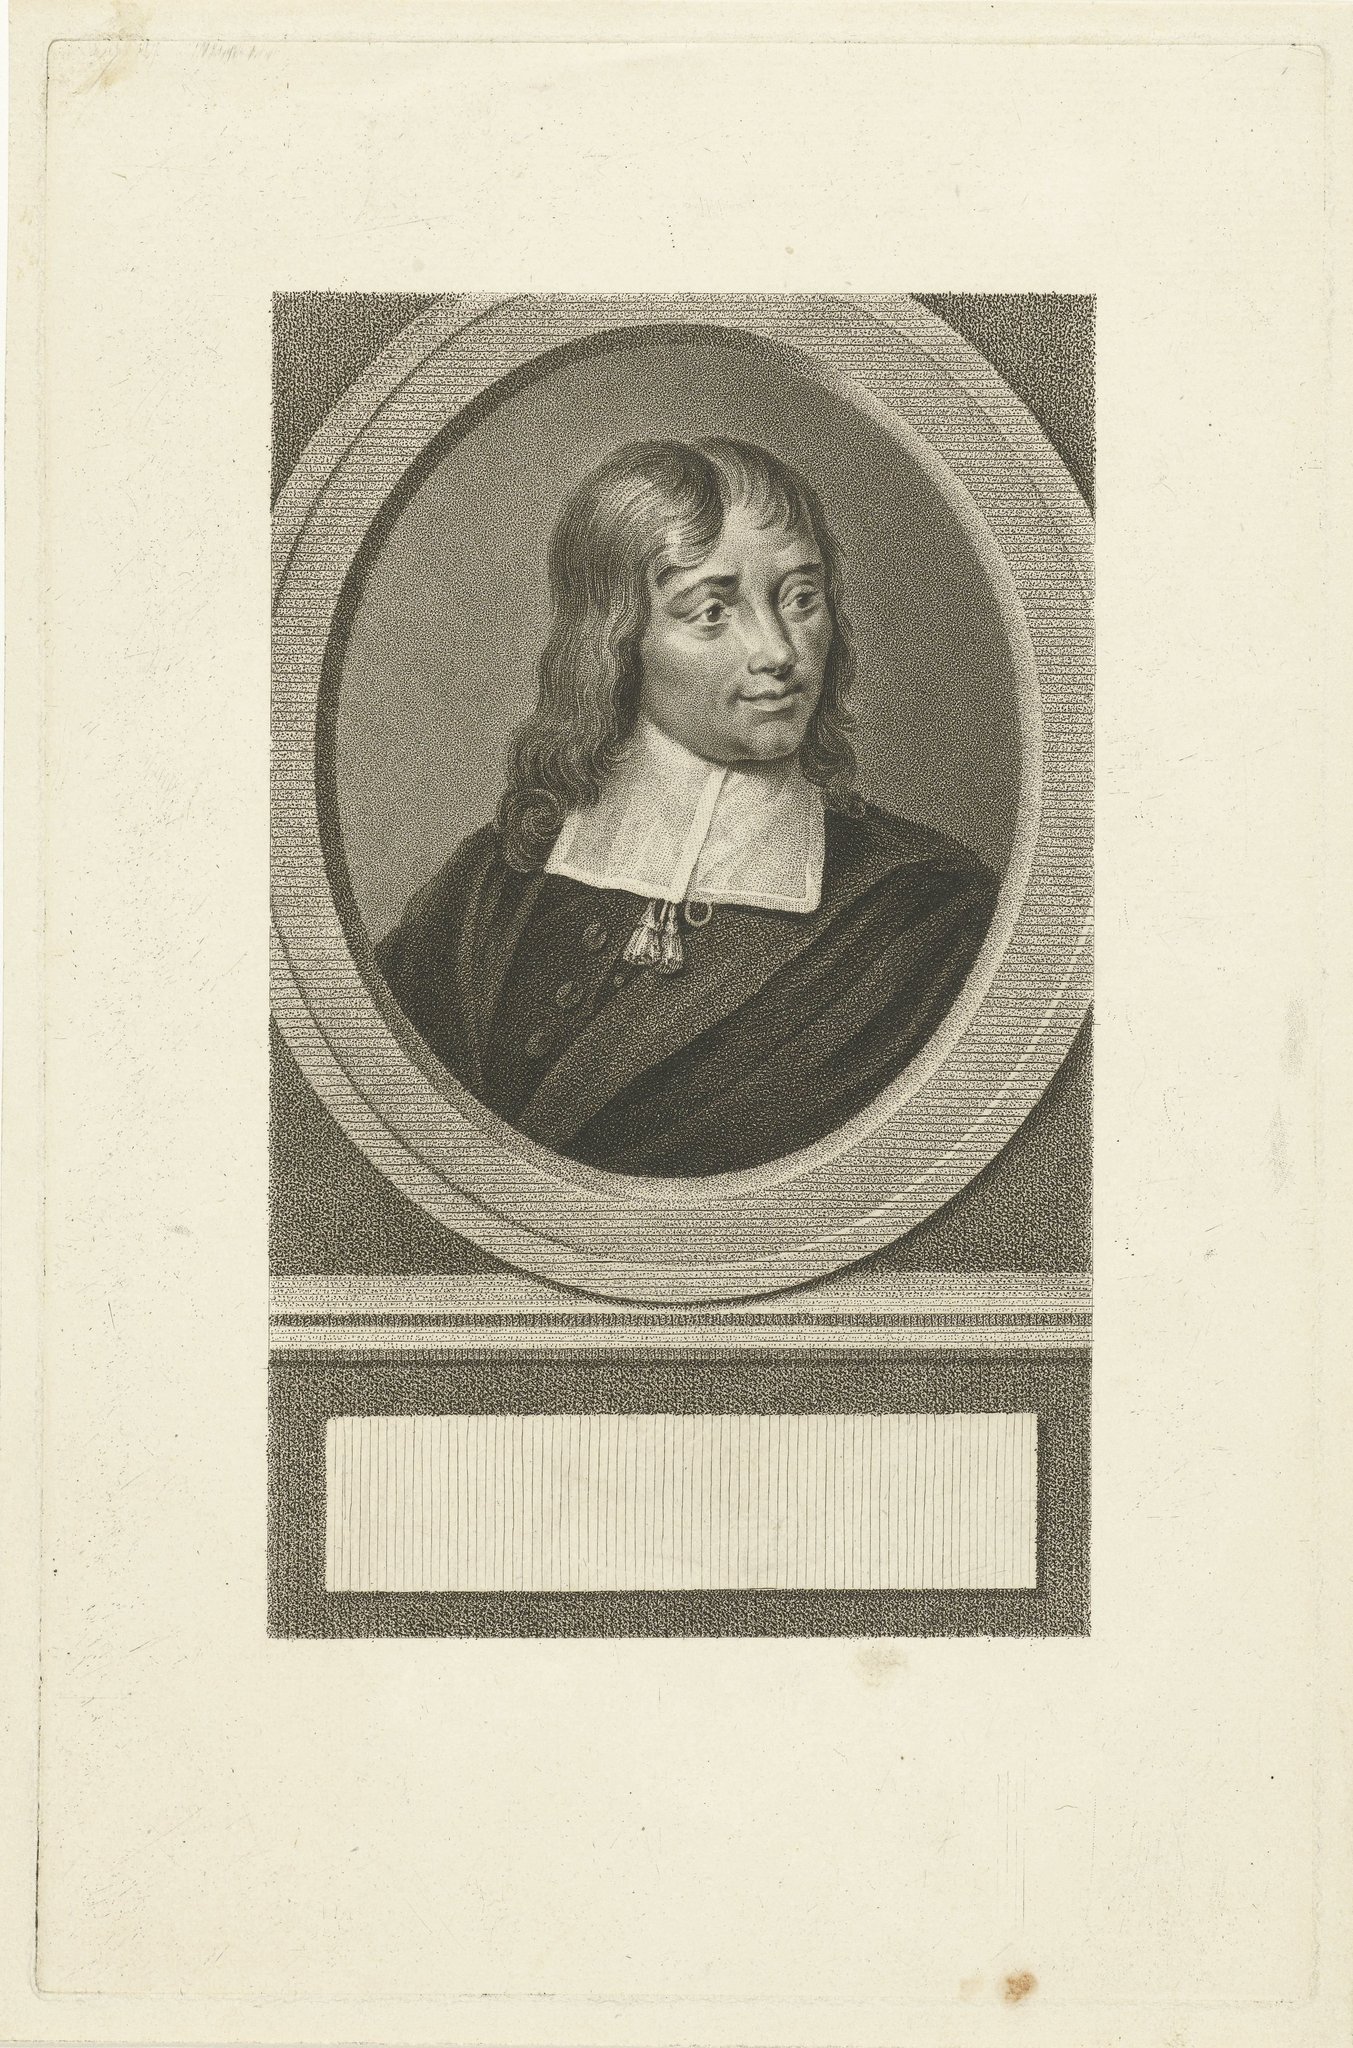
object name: print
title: Portret van Antonius Heinsius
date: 1792-1808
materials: paper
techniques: engraving, etching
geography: amsterdam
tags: delft, the hague, anthonie heinsius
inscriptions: collector's mark: Lugt 2228